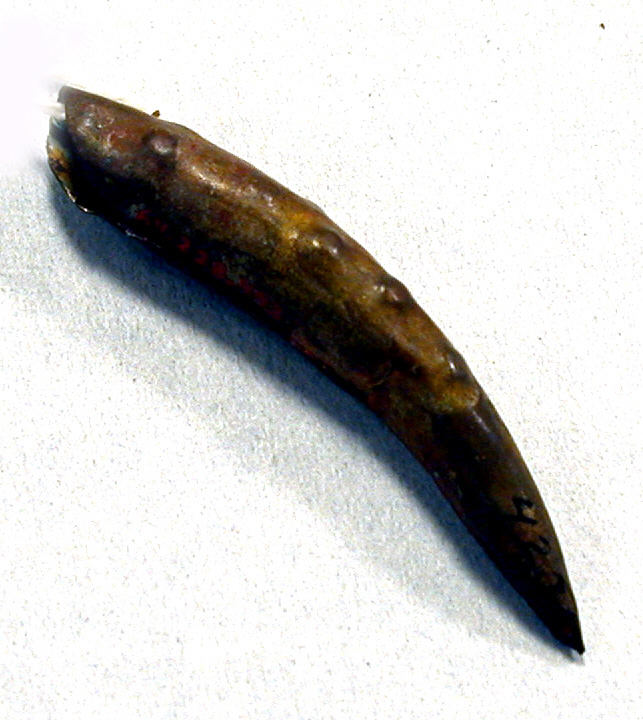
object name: ornament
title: Hammered Copper Claw Ornament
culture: peruvian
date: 701-1566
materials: copper, gilt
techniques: hammering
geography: peru